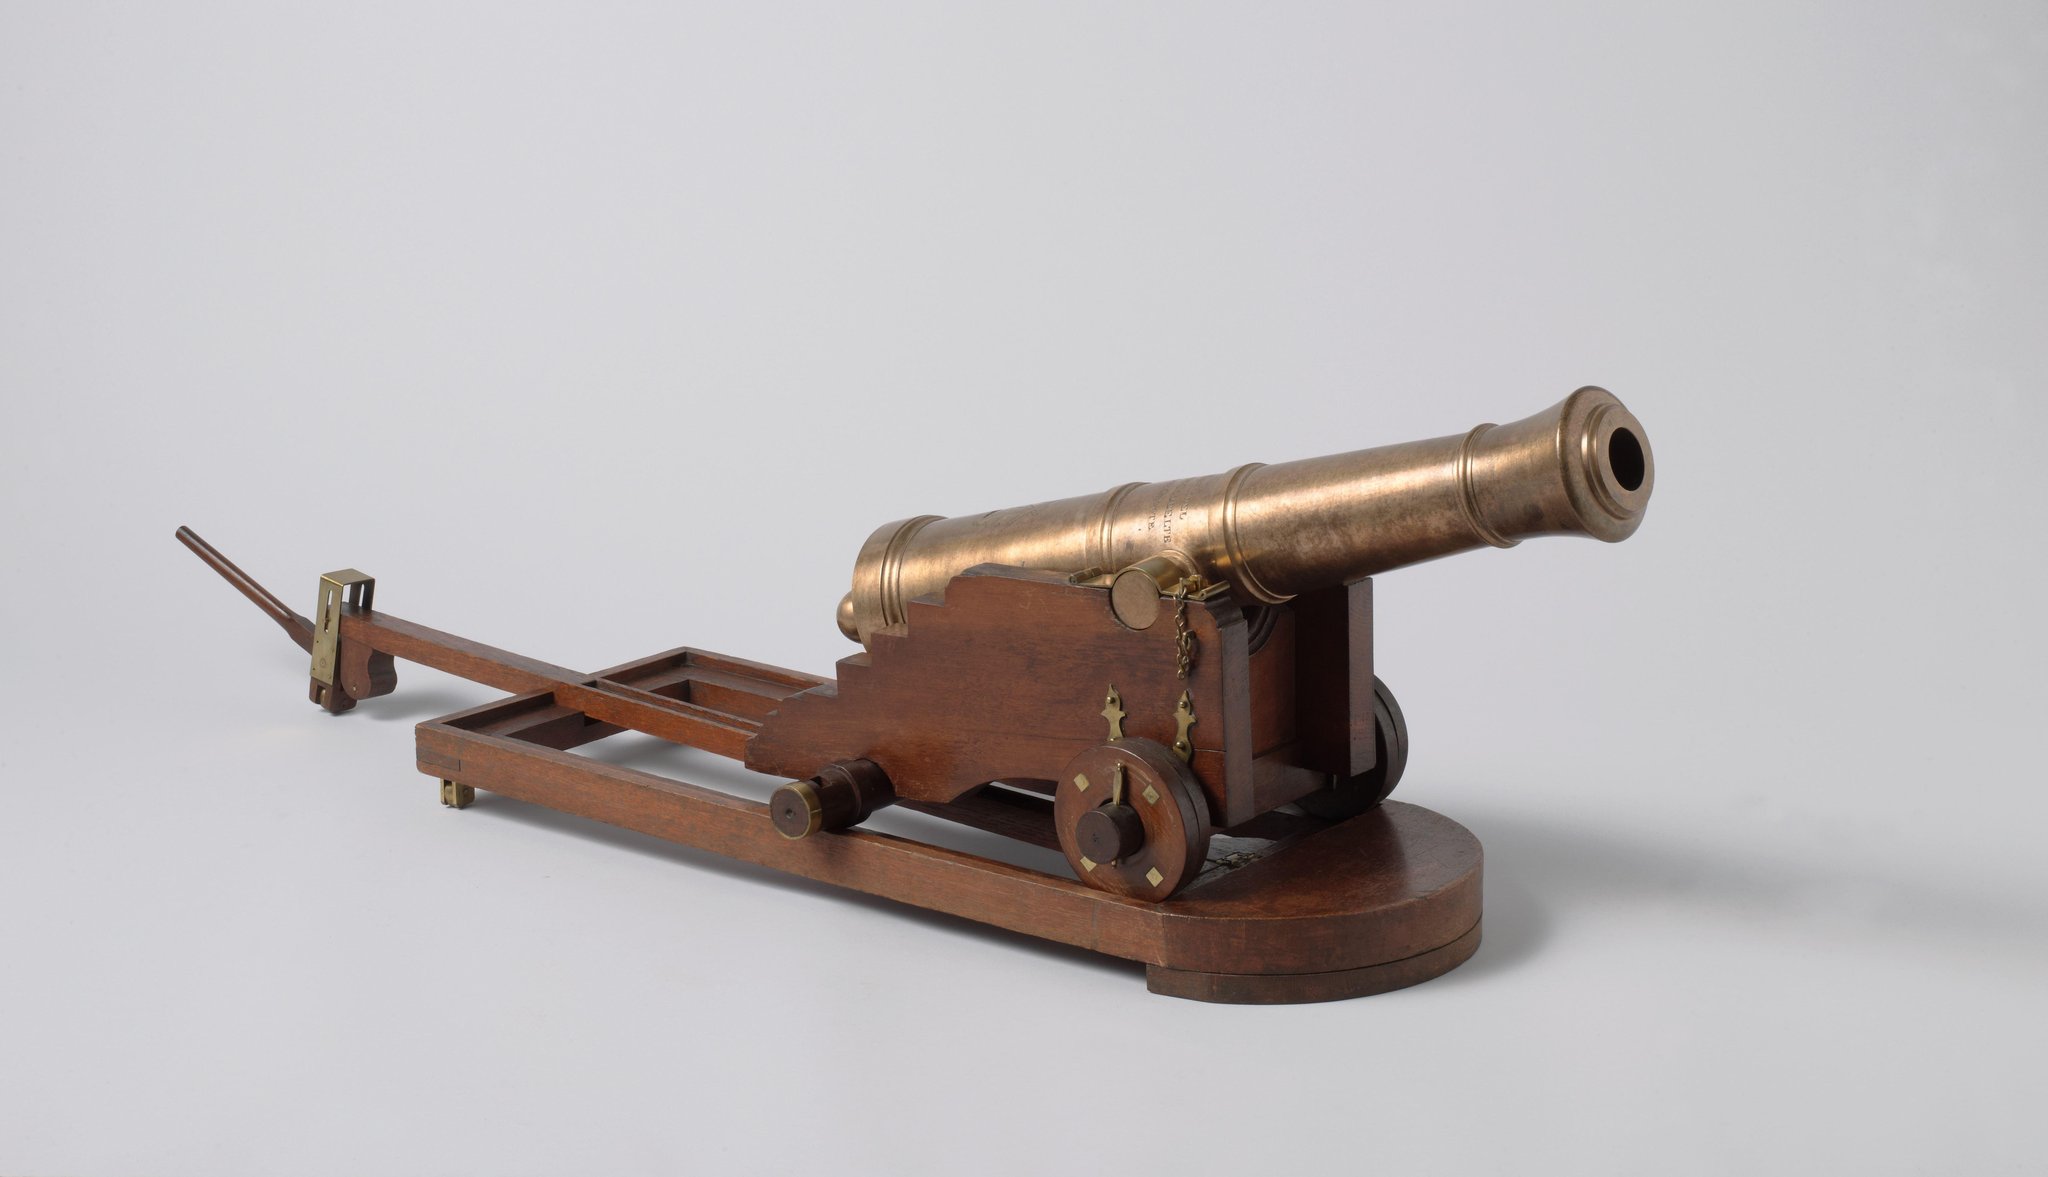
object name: demonstration model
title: Model of a 24-Pounder Gun on a Carriage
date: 1797-1800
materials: brass, bronze, wood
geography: france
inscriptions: monogram: ‘Am 1800 M’, inscription: ‘24 lbDR MODEL / EEN SESDE GEDEELTE / VAN DE WAARE GROOTE’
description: De loop is een stuk uit een serie met hetzelfde type opschrift. De schaal op het model is onjuist: meting wijst op een kanon van 60 pond in plaats van 24 pond. Het model van het affuit werd ofwel aan J.P. Asmus geschonken tijdens diens bezoek aan de cabinetten van Montalembert in 1797, ofwel hij heeft het model laten maken naar notities die hij tijdens dit bezoek maakte: Asmus vernoemt het model in de modellenkamer van de Rijkswerf te Amsterdam in 1801. De loop is waarschijnlijk naderhand toegevoegd: het gewicht ervan belemmert de werking van het affuitmodel. Het affuit is bijna identiek aan dat van NG-MC-770, behalve de de beugels waarmee het voorste aslijf aan het rolpaard is bevestigd en de samenstelling der wielen. De slede en achteras zijn gescheiden van het affuit gevonden en de samenvoeging blijft giswerk.